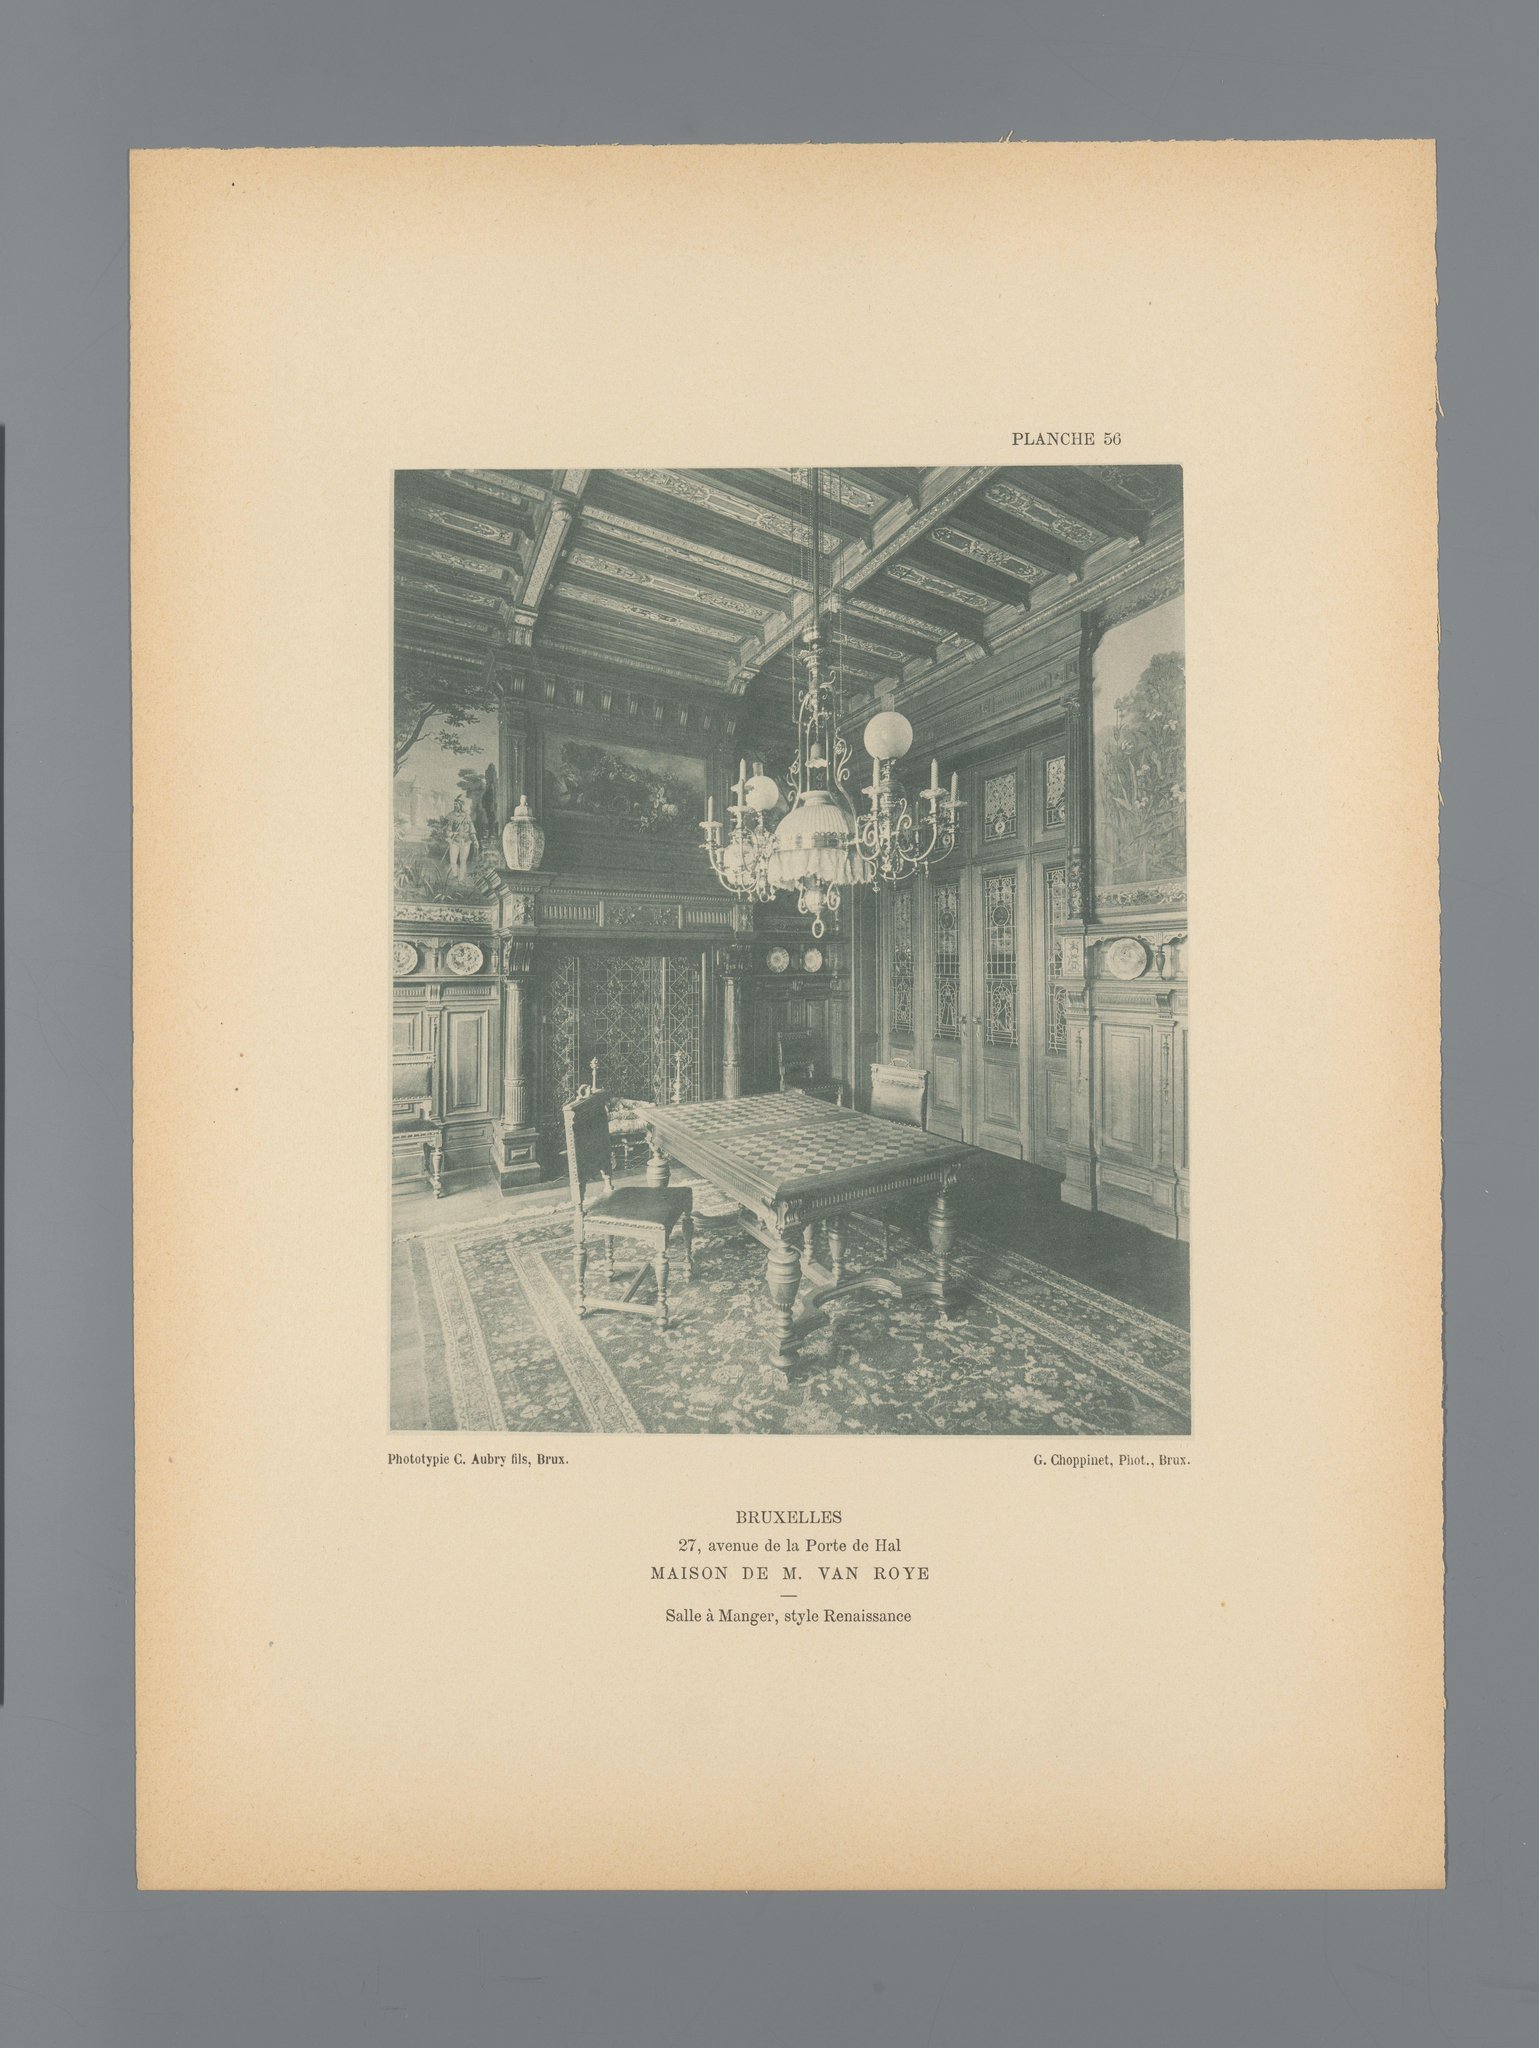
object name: photomechanical print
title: Bruxelles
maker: gustave choppinet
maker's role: fotograaf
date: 1893-1898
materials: paper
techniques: photograph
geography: brussels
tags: interior of the house, dining-room, brussels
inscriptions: inscription: ‘27, avenue de la Porte de Hal/ MAISON DE M. VAN ROYE/ Salle à Manger, style Renaissance’, number: ‘PLANCHE 56’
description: Deze prent maakt deel uit van een omslag met 89 prenten en 5 tekstbladen.